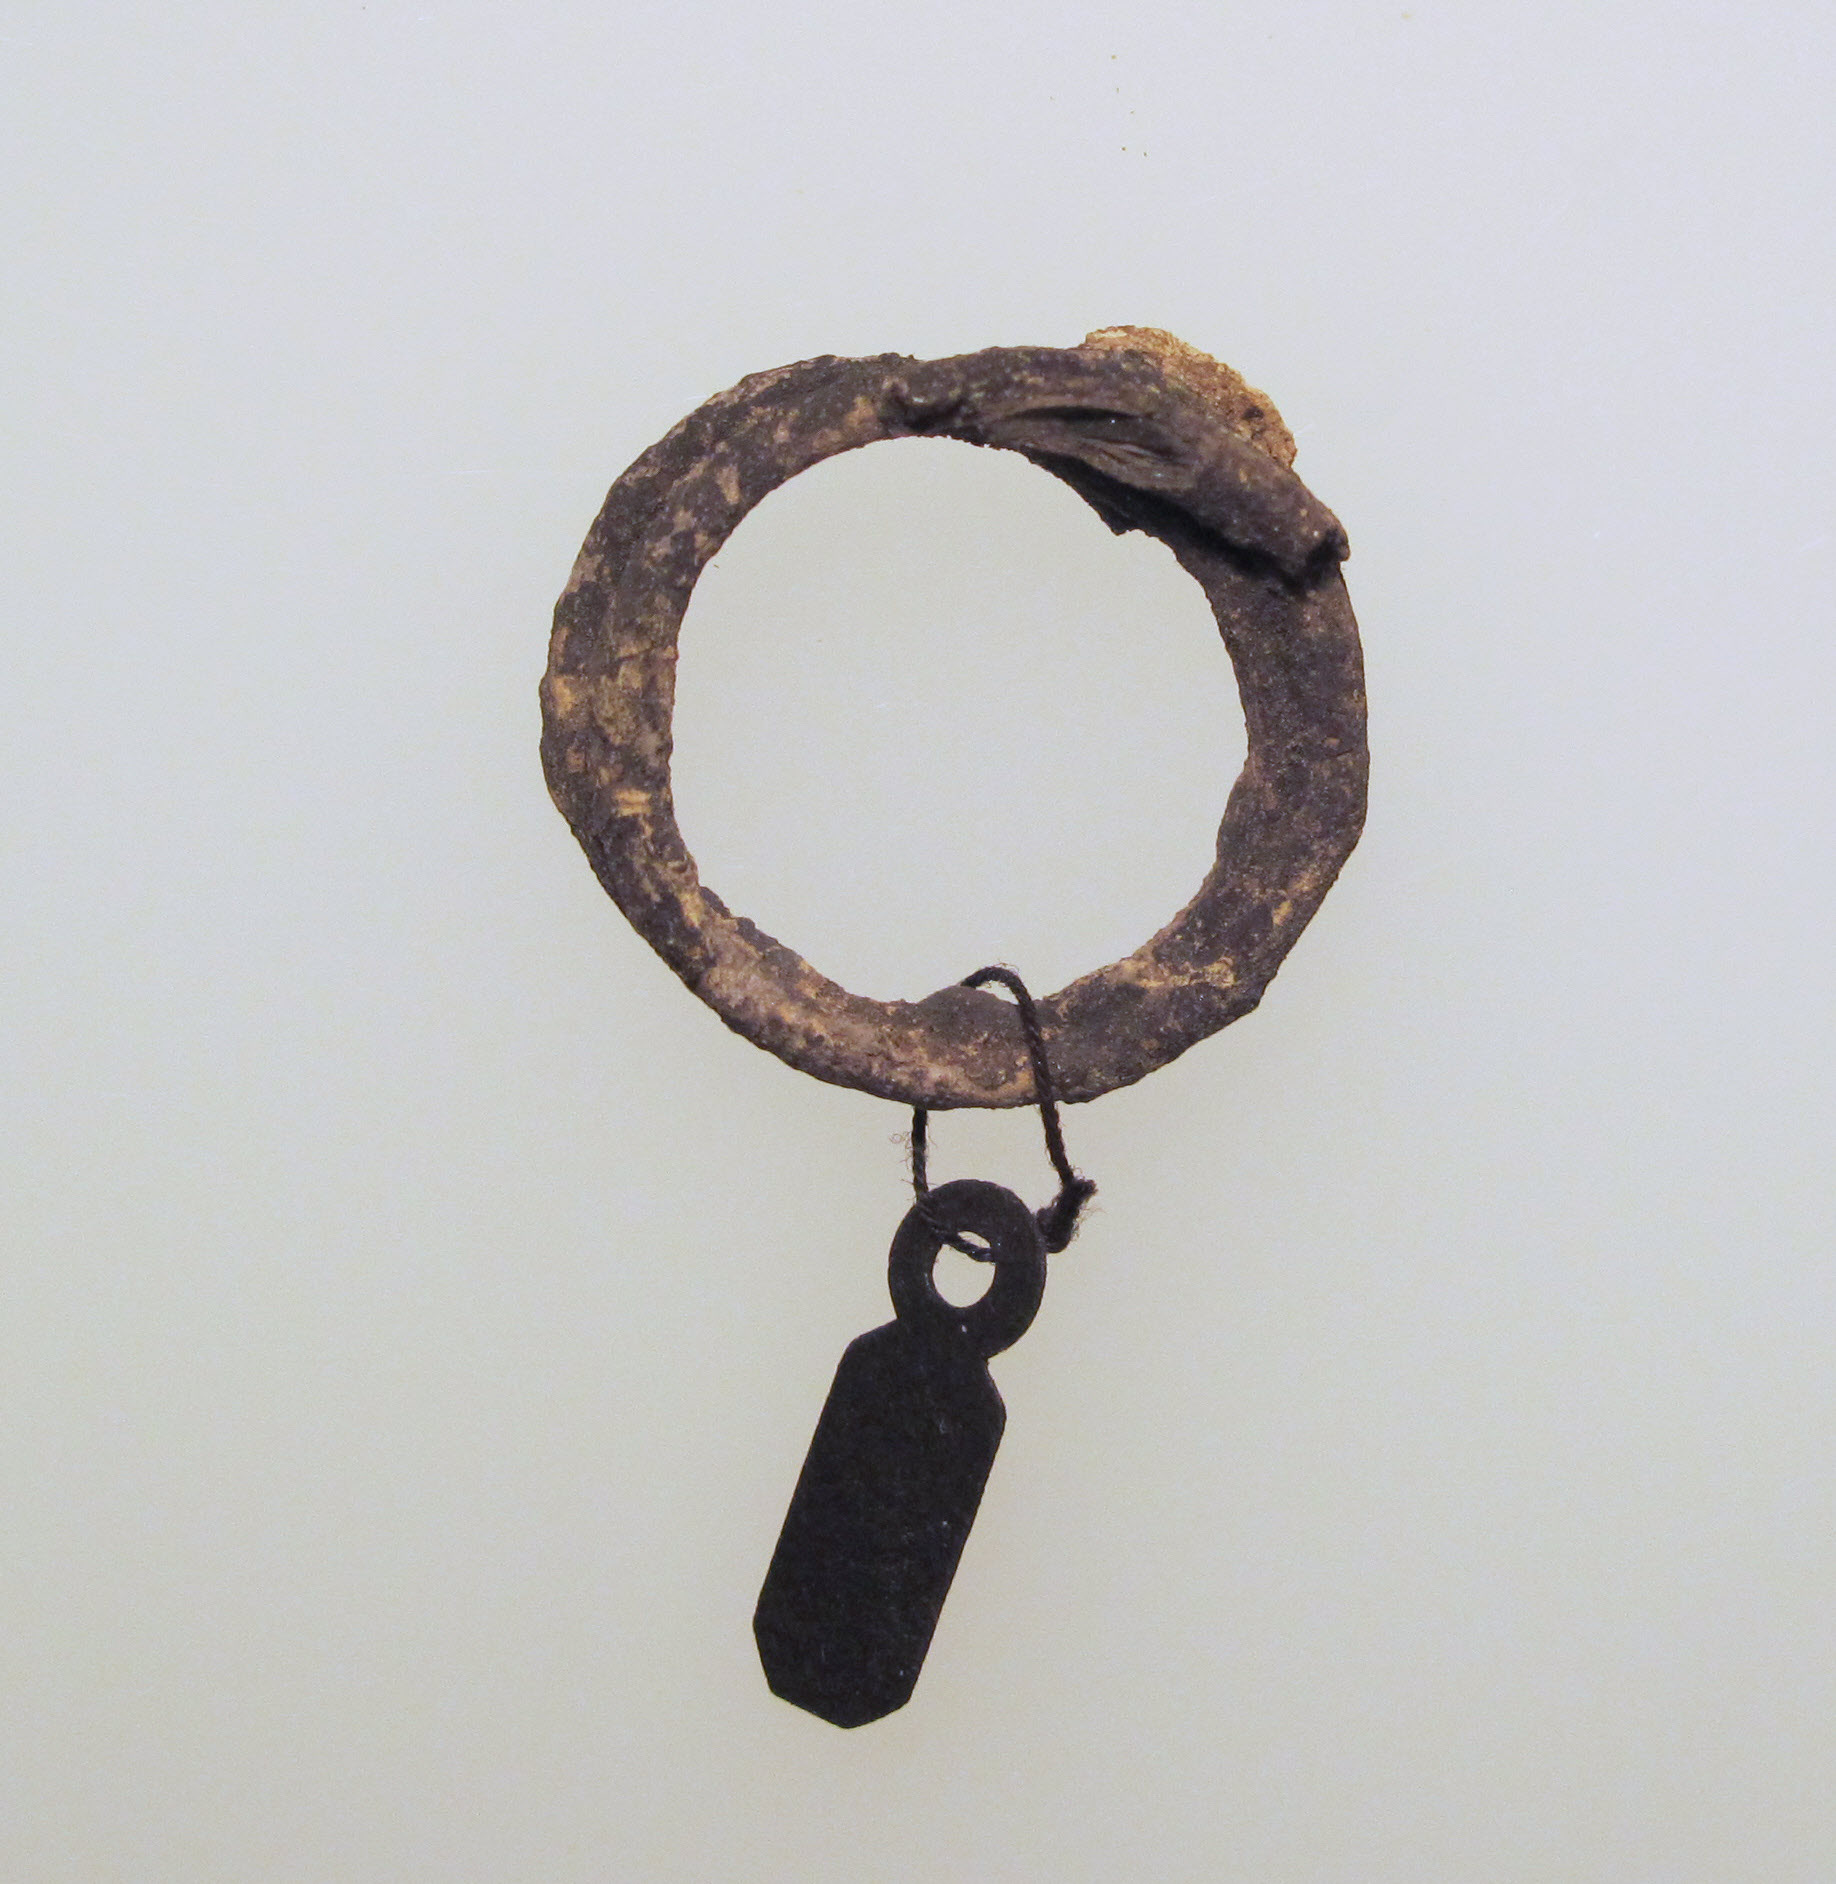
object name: spiral, 2 coil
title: Silver spiral, 2 coils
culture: cypriot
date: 3900 BCE-100 CE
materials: silver